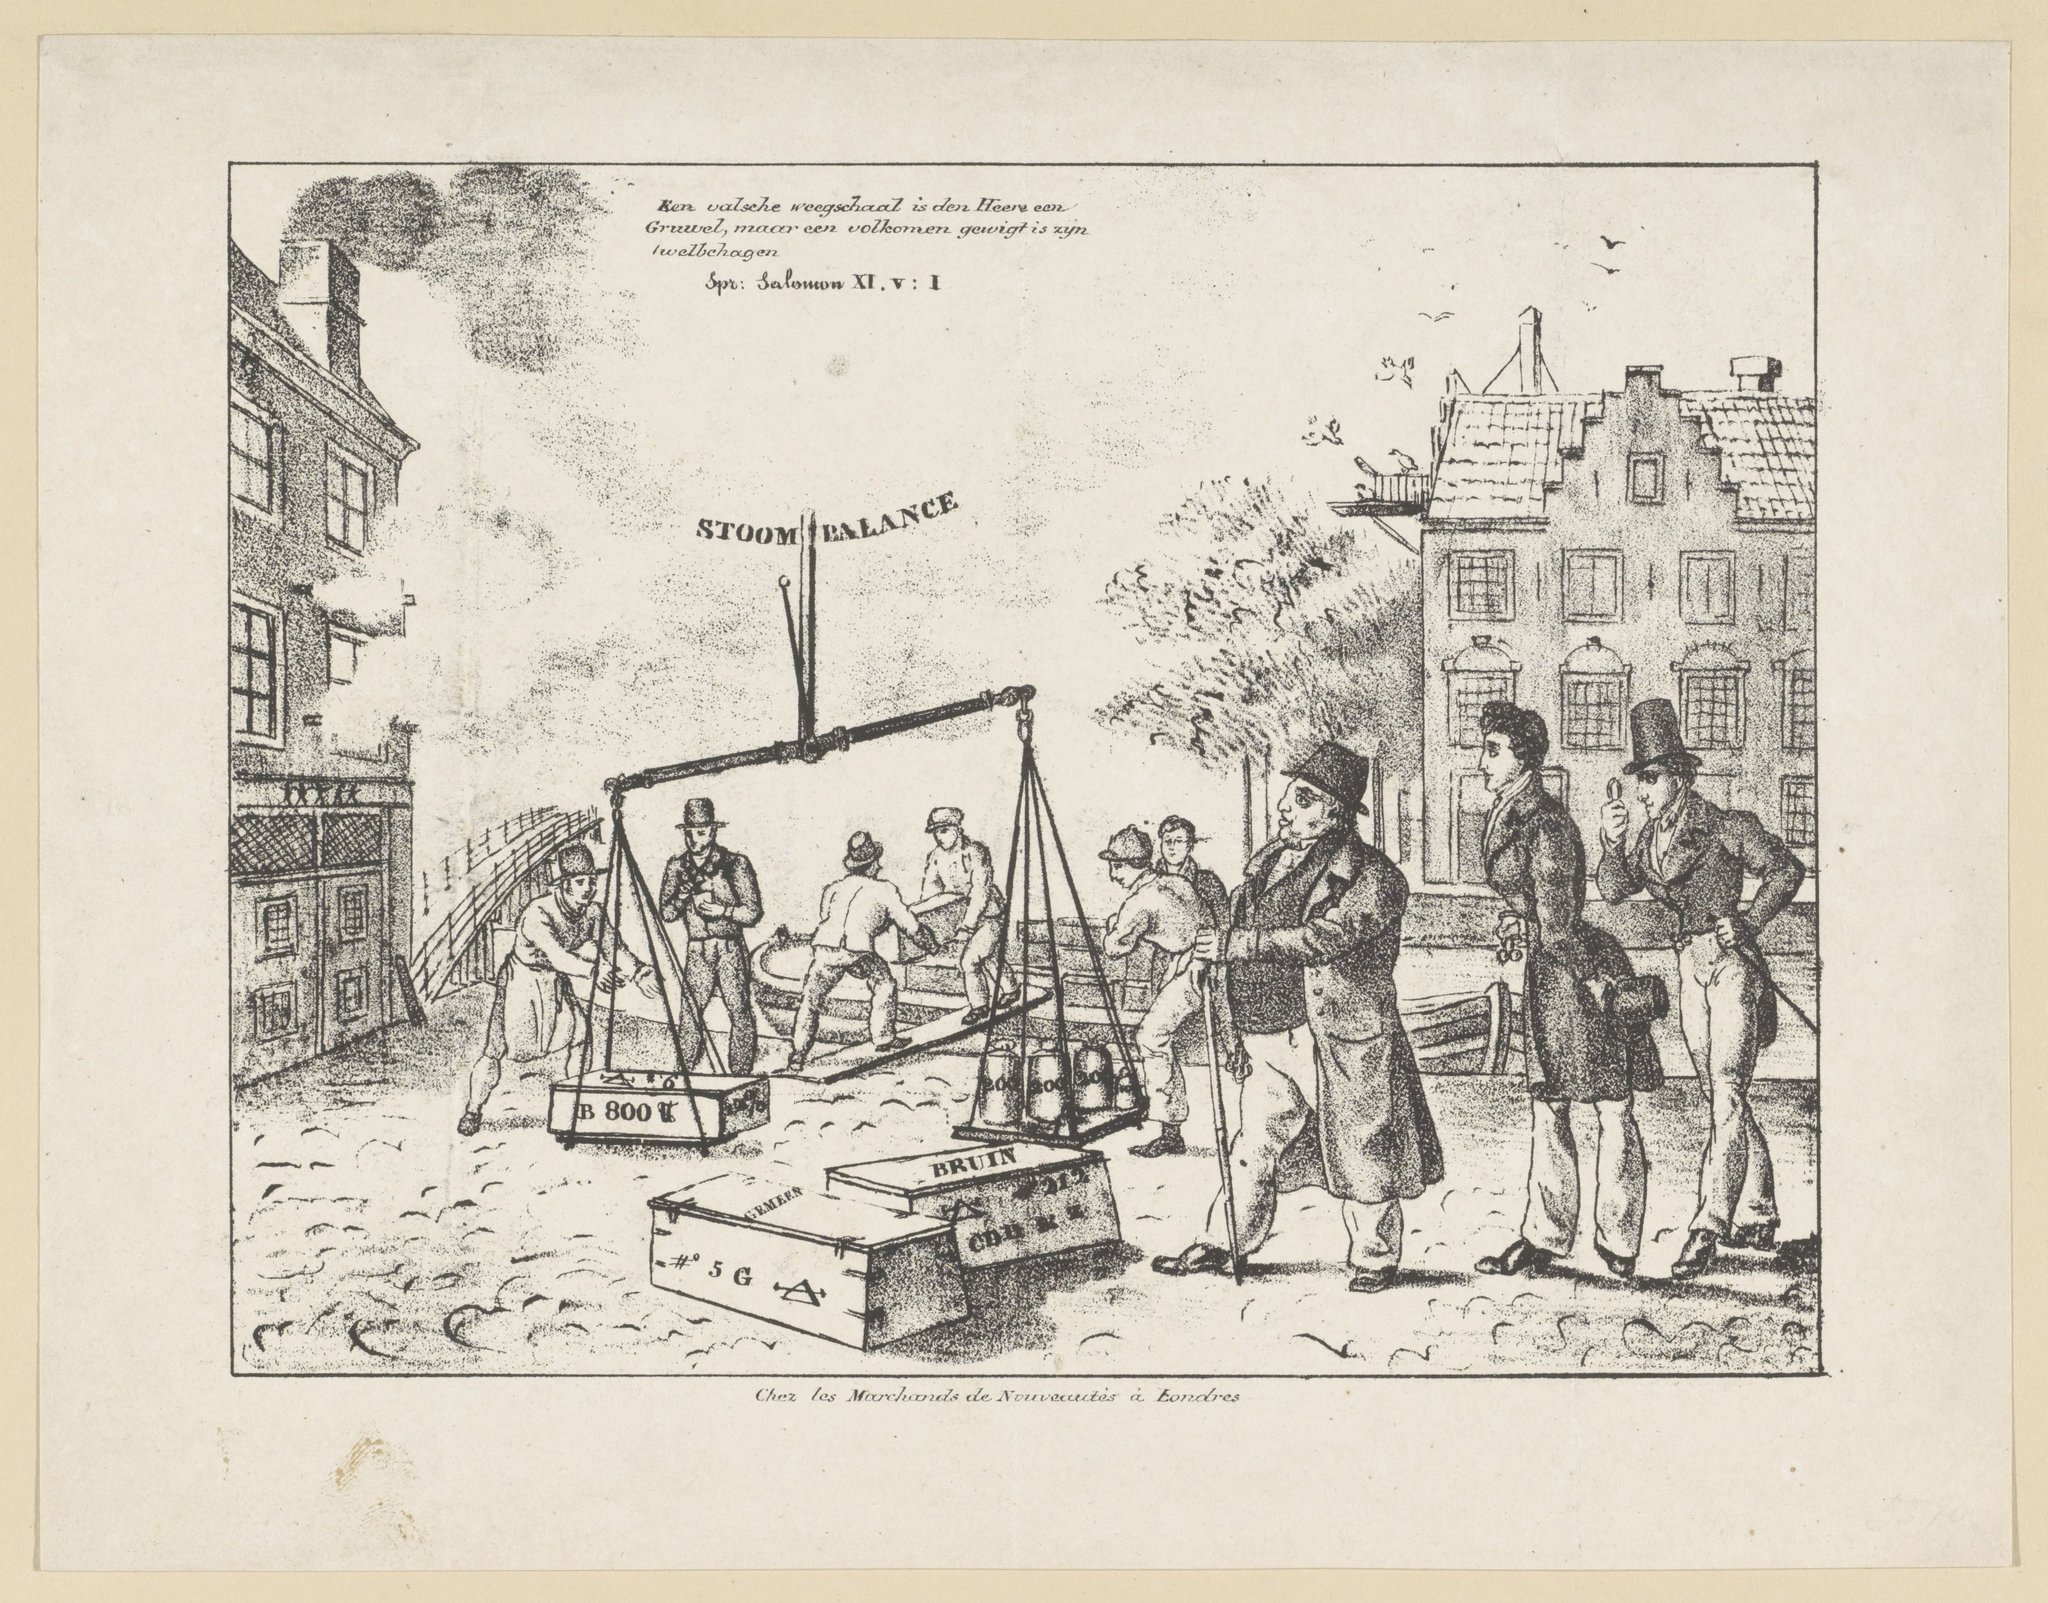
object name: print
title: Spotprent op het bedrog van de firma C. de Bruyn & Zonen, 1834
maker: Anonymous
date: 1834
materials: paper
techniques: lithograph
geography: netherlands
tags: fraudulence, swindling, scales, industries ~ food, drink, stimulants, sugar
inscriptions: collector's mark: Lugt 2228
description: Spotprent op het bedrog met een valse weegschaal van de firma C. de Bruyn & Zonen, 1834. De firma bezat de eerste stoomsuikerraffinaderij aan de Lijnbaansgracht in Amsterdam. Op 8 januari 1834 werden zij betrapt op het gebruik van een balans waarvan een arm was verlengd. Centraal de valse balans hangend aan de stoomwolken die uit de fabriek 'De Vijf Gebroeders' komen en waarop kisten met suiker worden gewogen. Rechts C. de Bruyn met zijn twee zoons. In de wolken een bijbelcitaat.